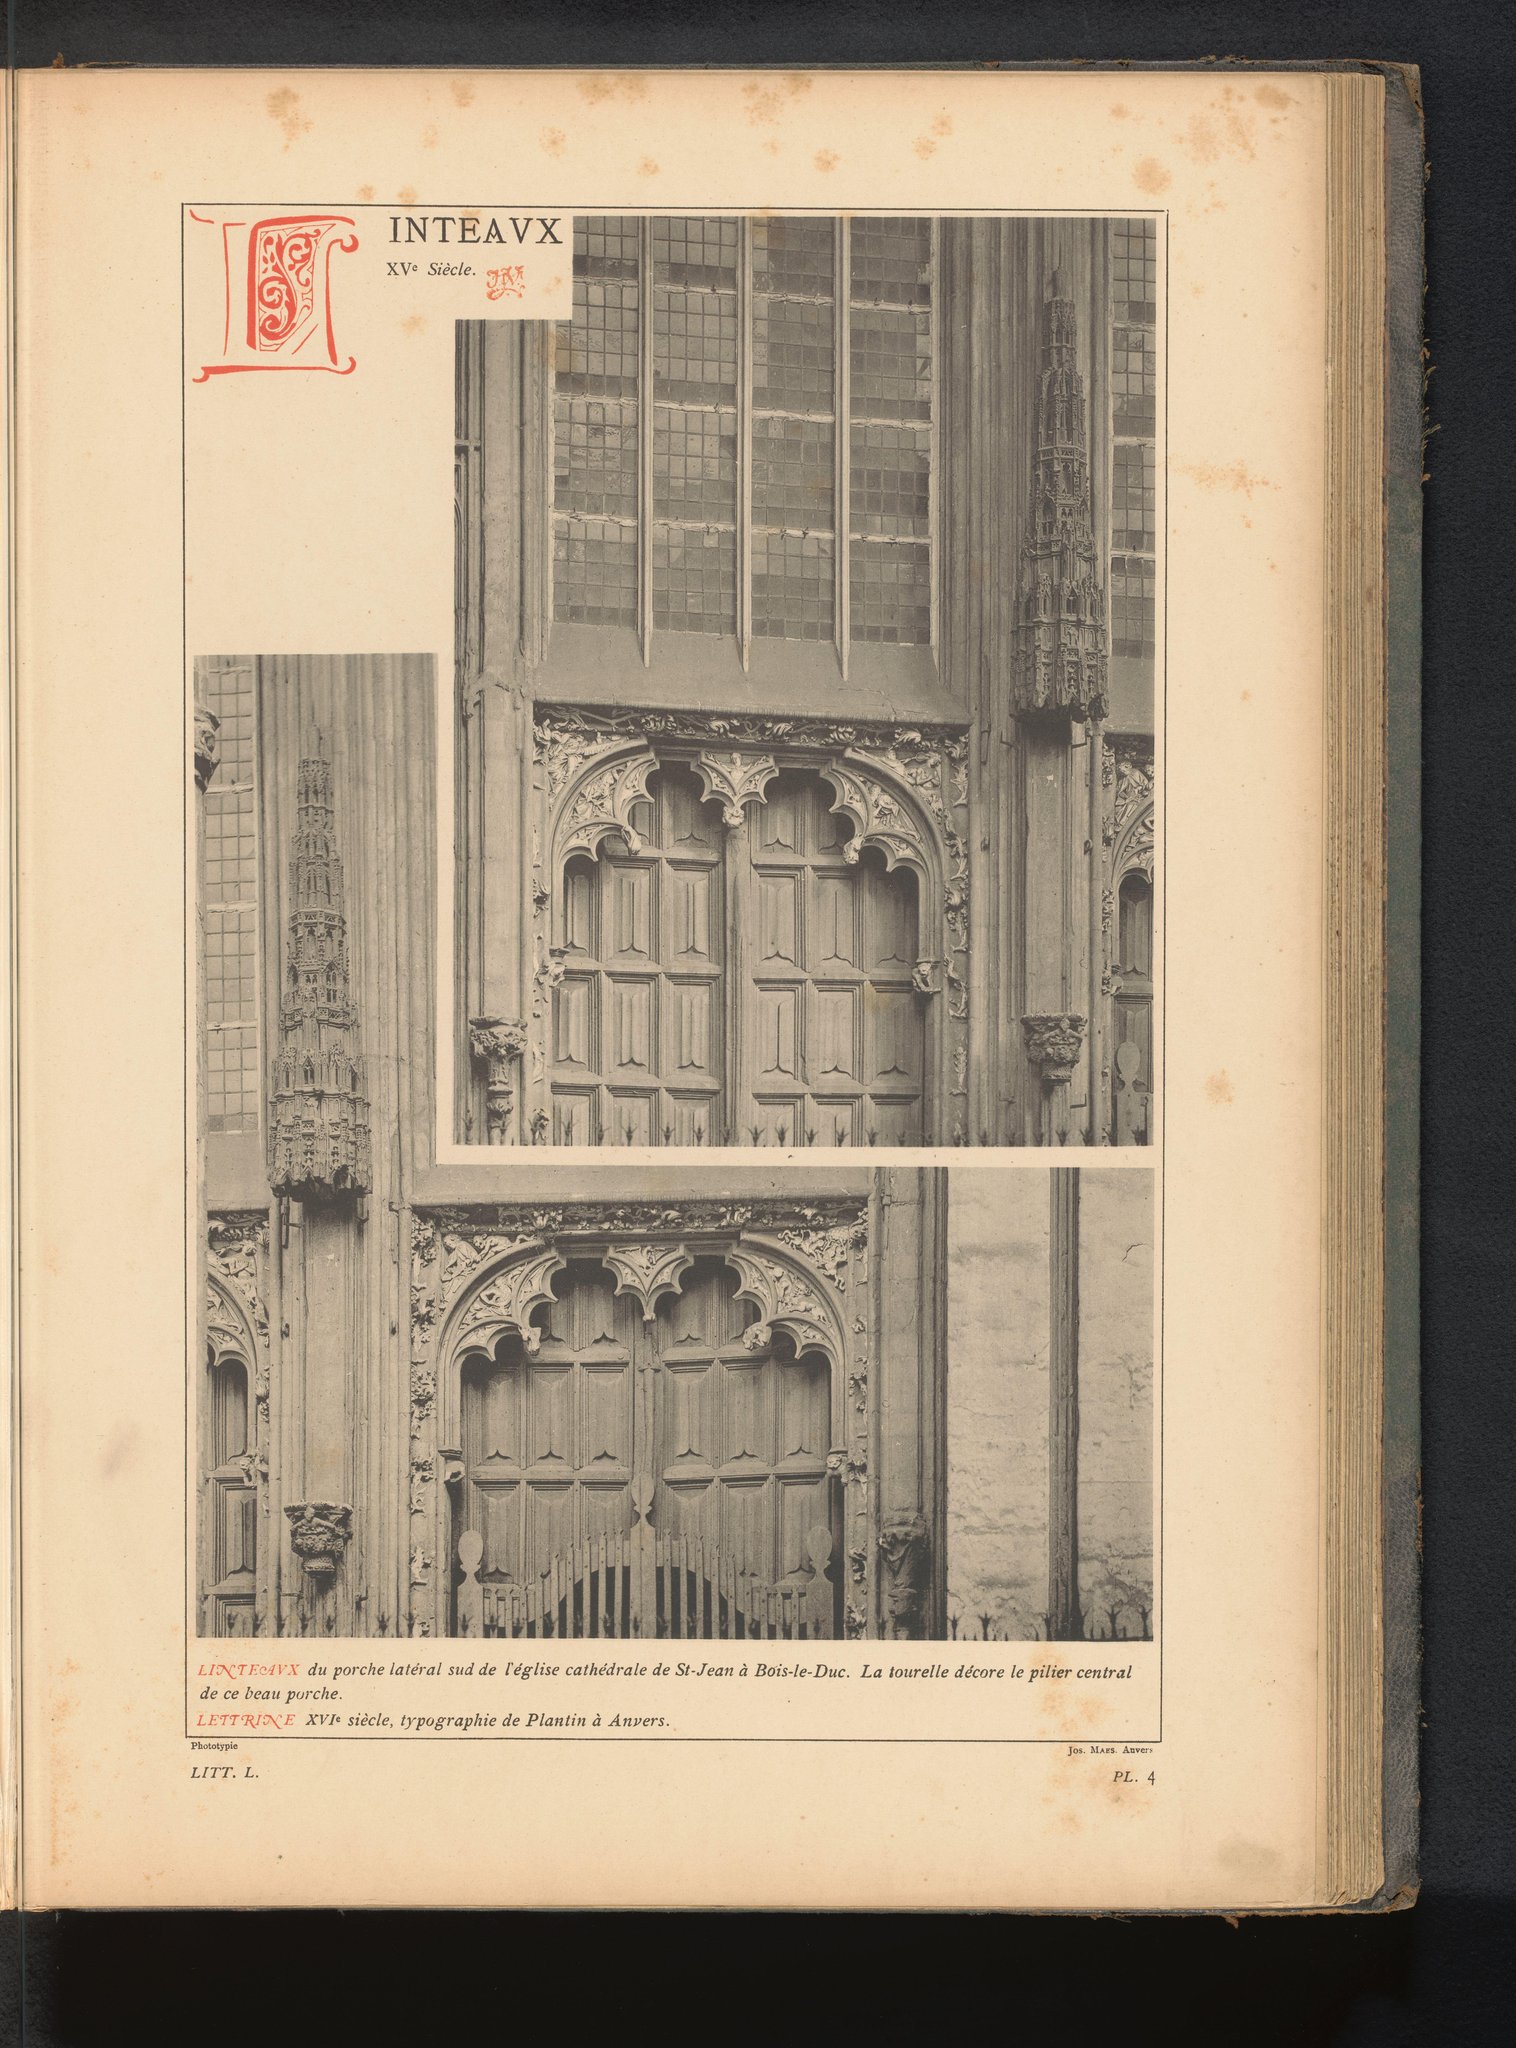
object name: page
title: Linteaux, XVe Siècle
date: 1875-1880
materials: paper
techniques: photograph, photolithography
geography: den bosch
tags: church (exterior), closed door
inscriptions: inscription: ‘LITT. L. - PL. 4’, monogram: ‘JJvY’, inscription: ‘LINTEAUX du porche (...)’